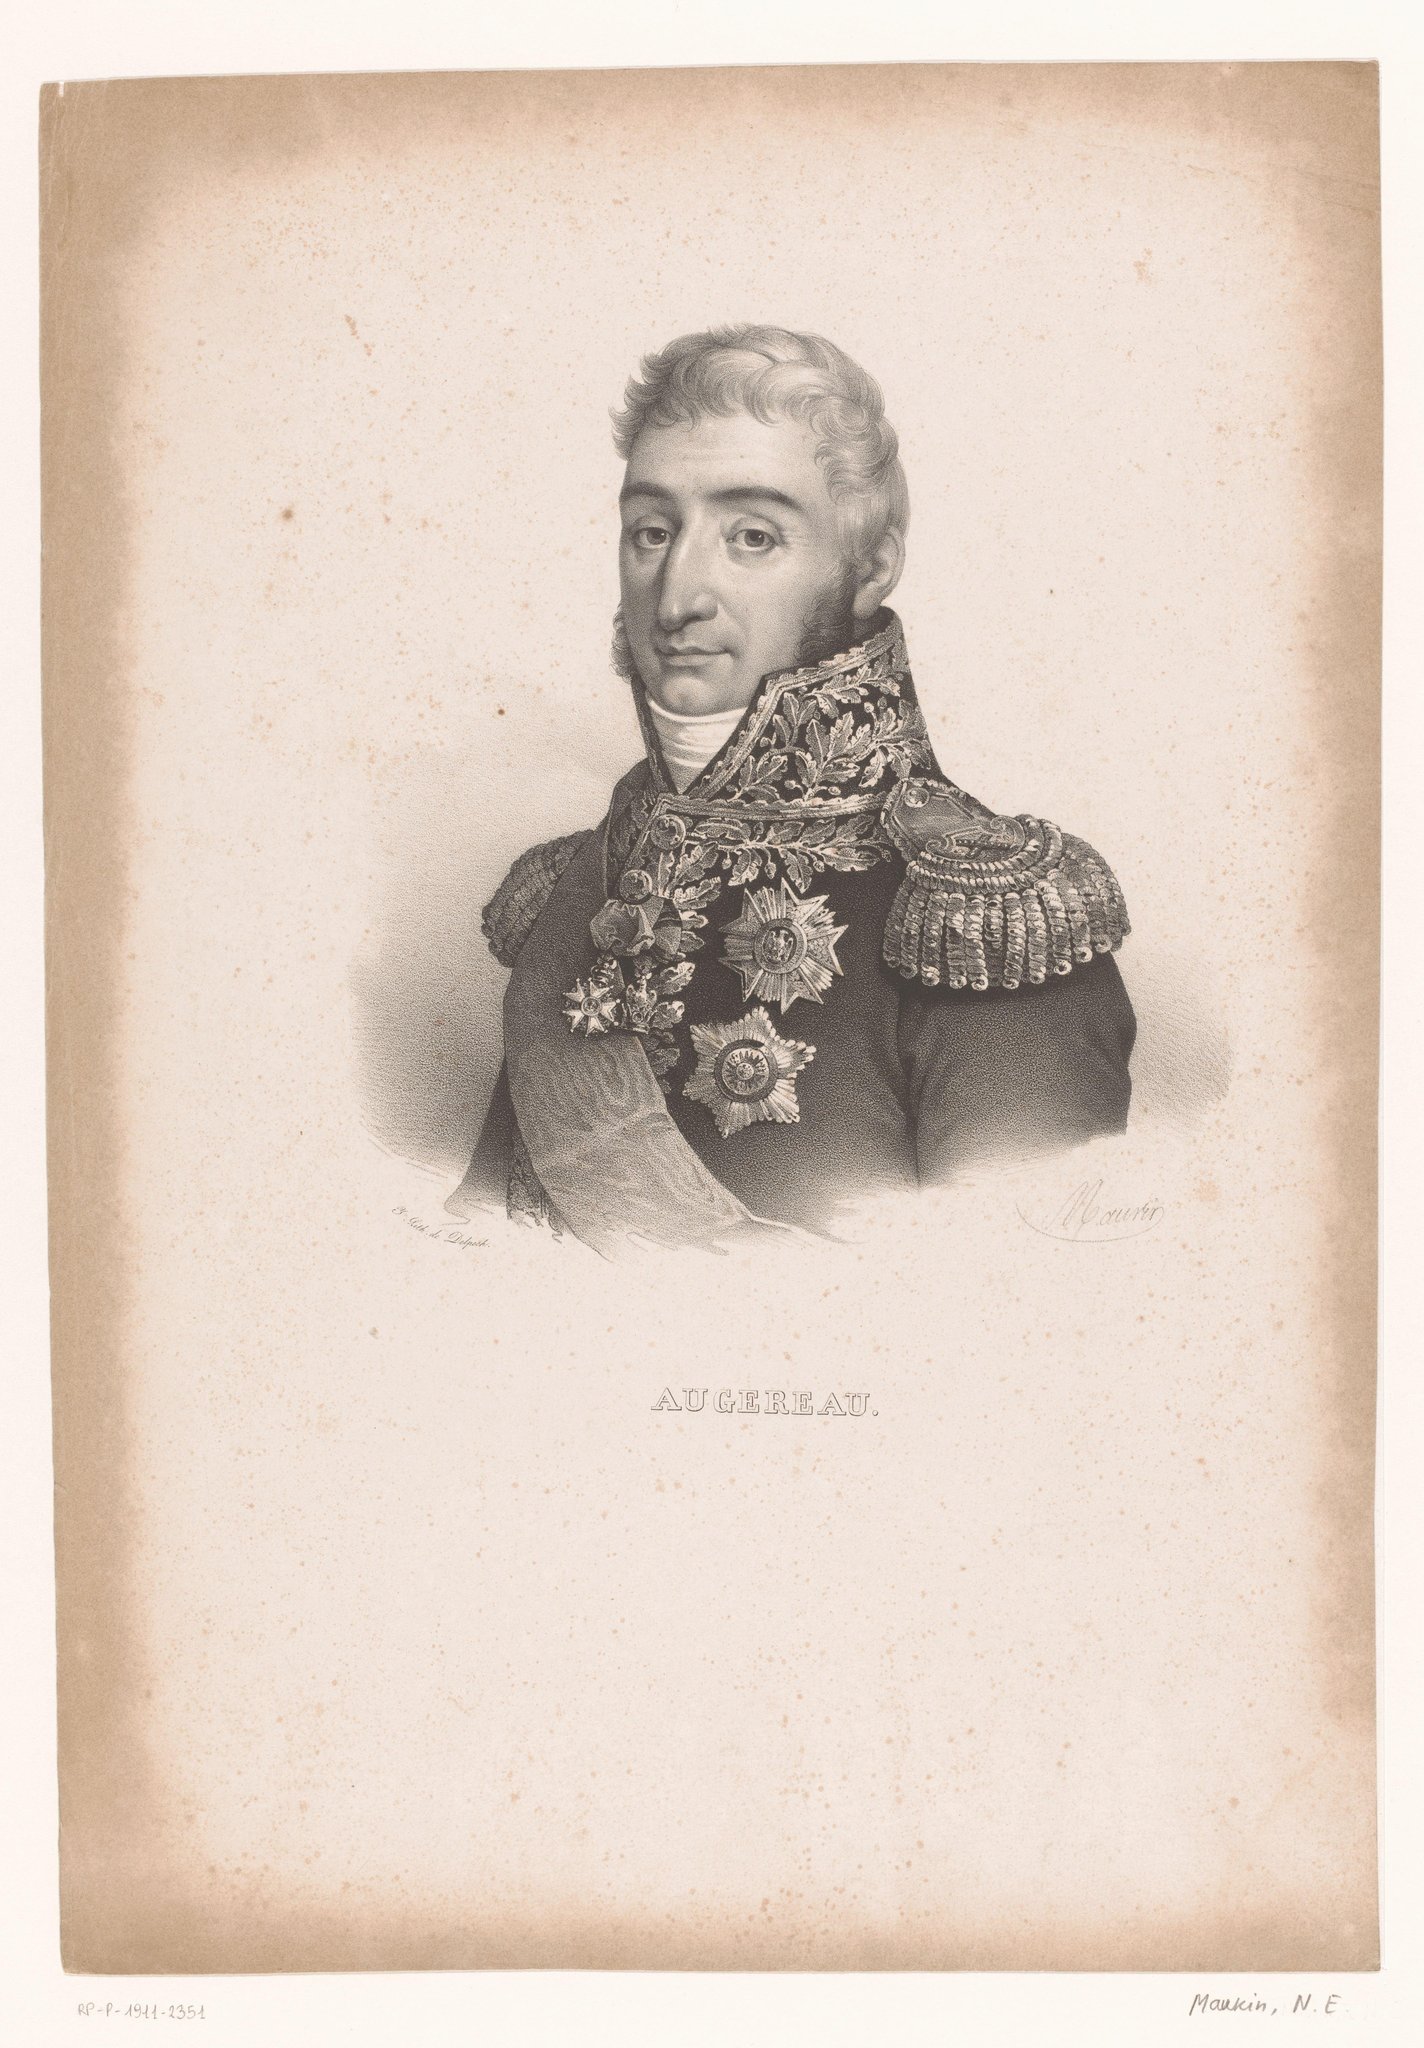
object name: print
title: Portret van Pierre François Charles Augereau, hertog van Castiglione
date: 1825-1842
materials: paper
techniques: lithograph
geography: paris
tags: historical persons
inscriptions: collector's mark: Lugt 2228